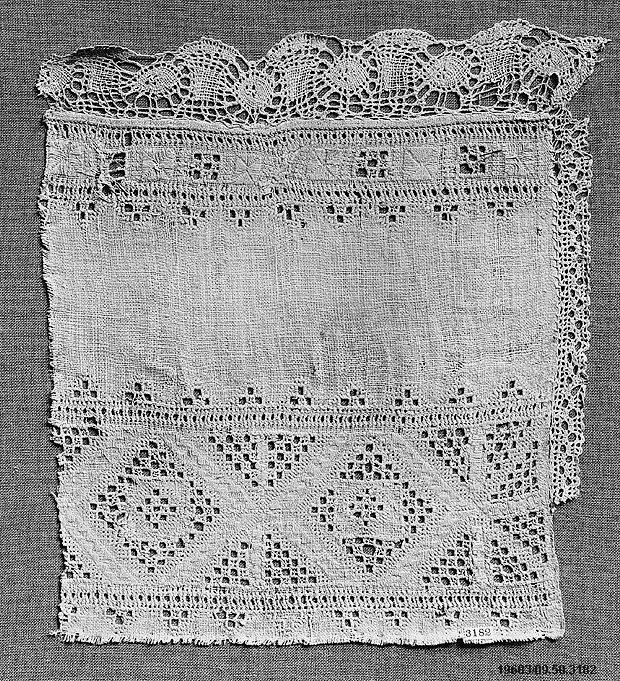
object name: fragment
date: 1701-1800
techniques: lace